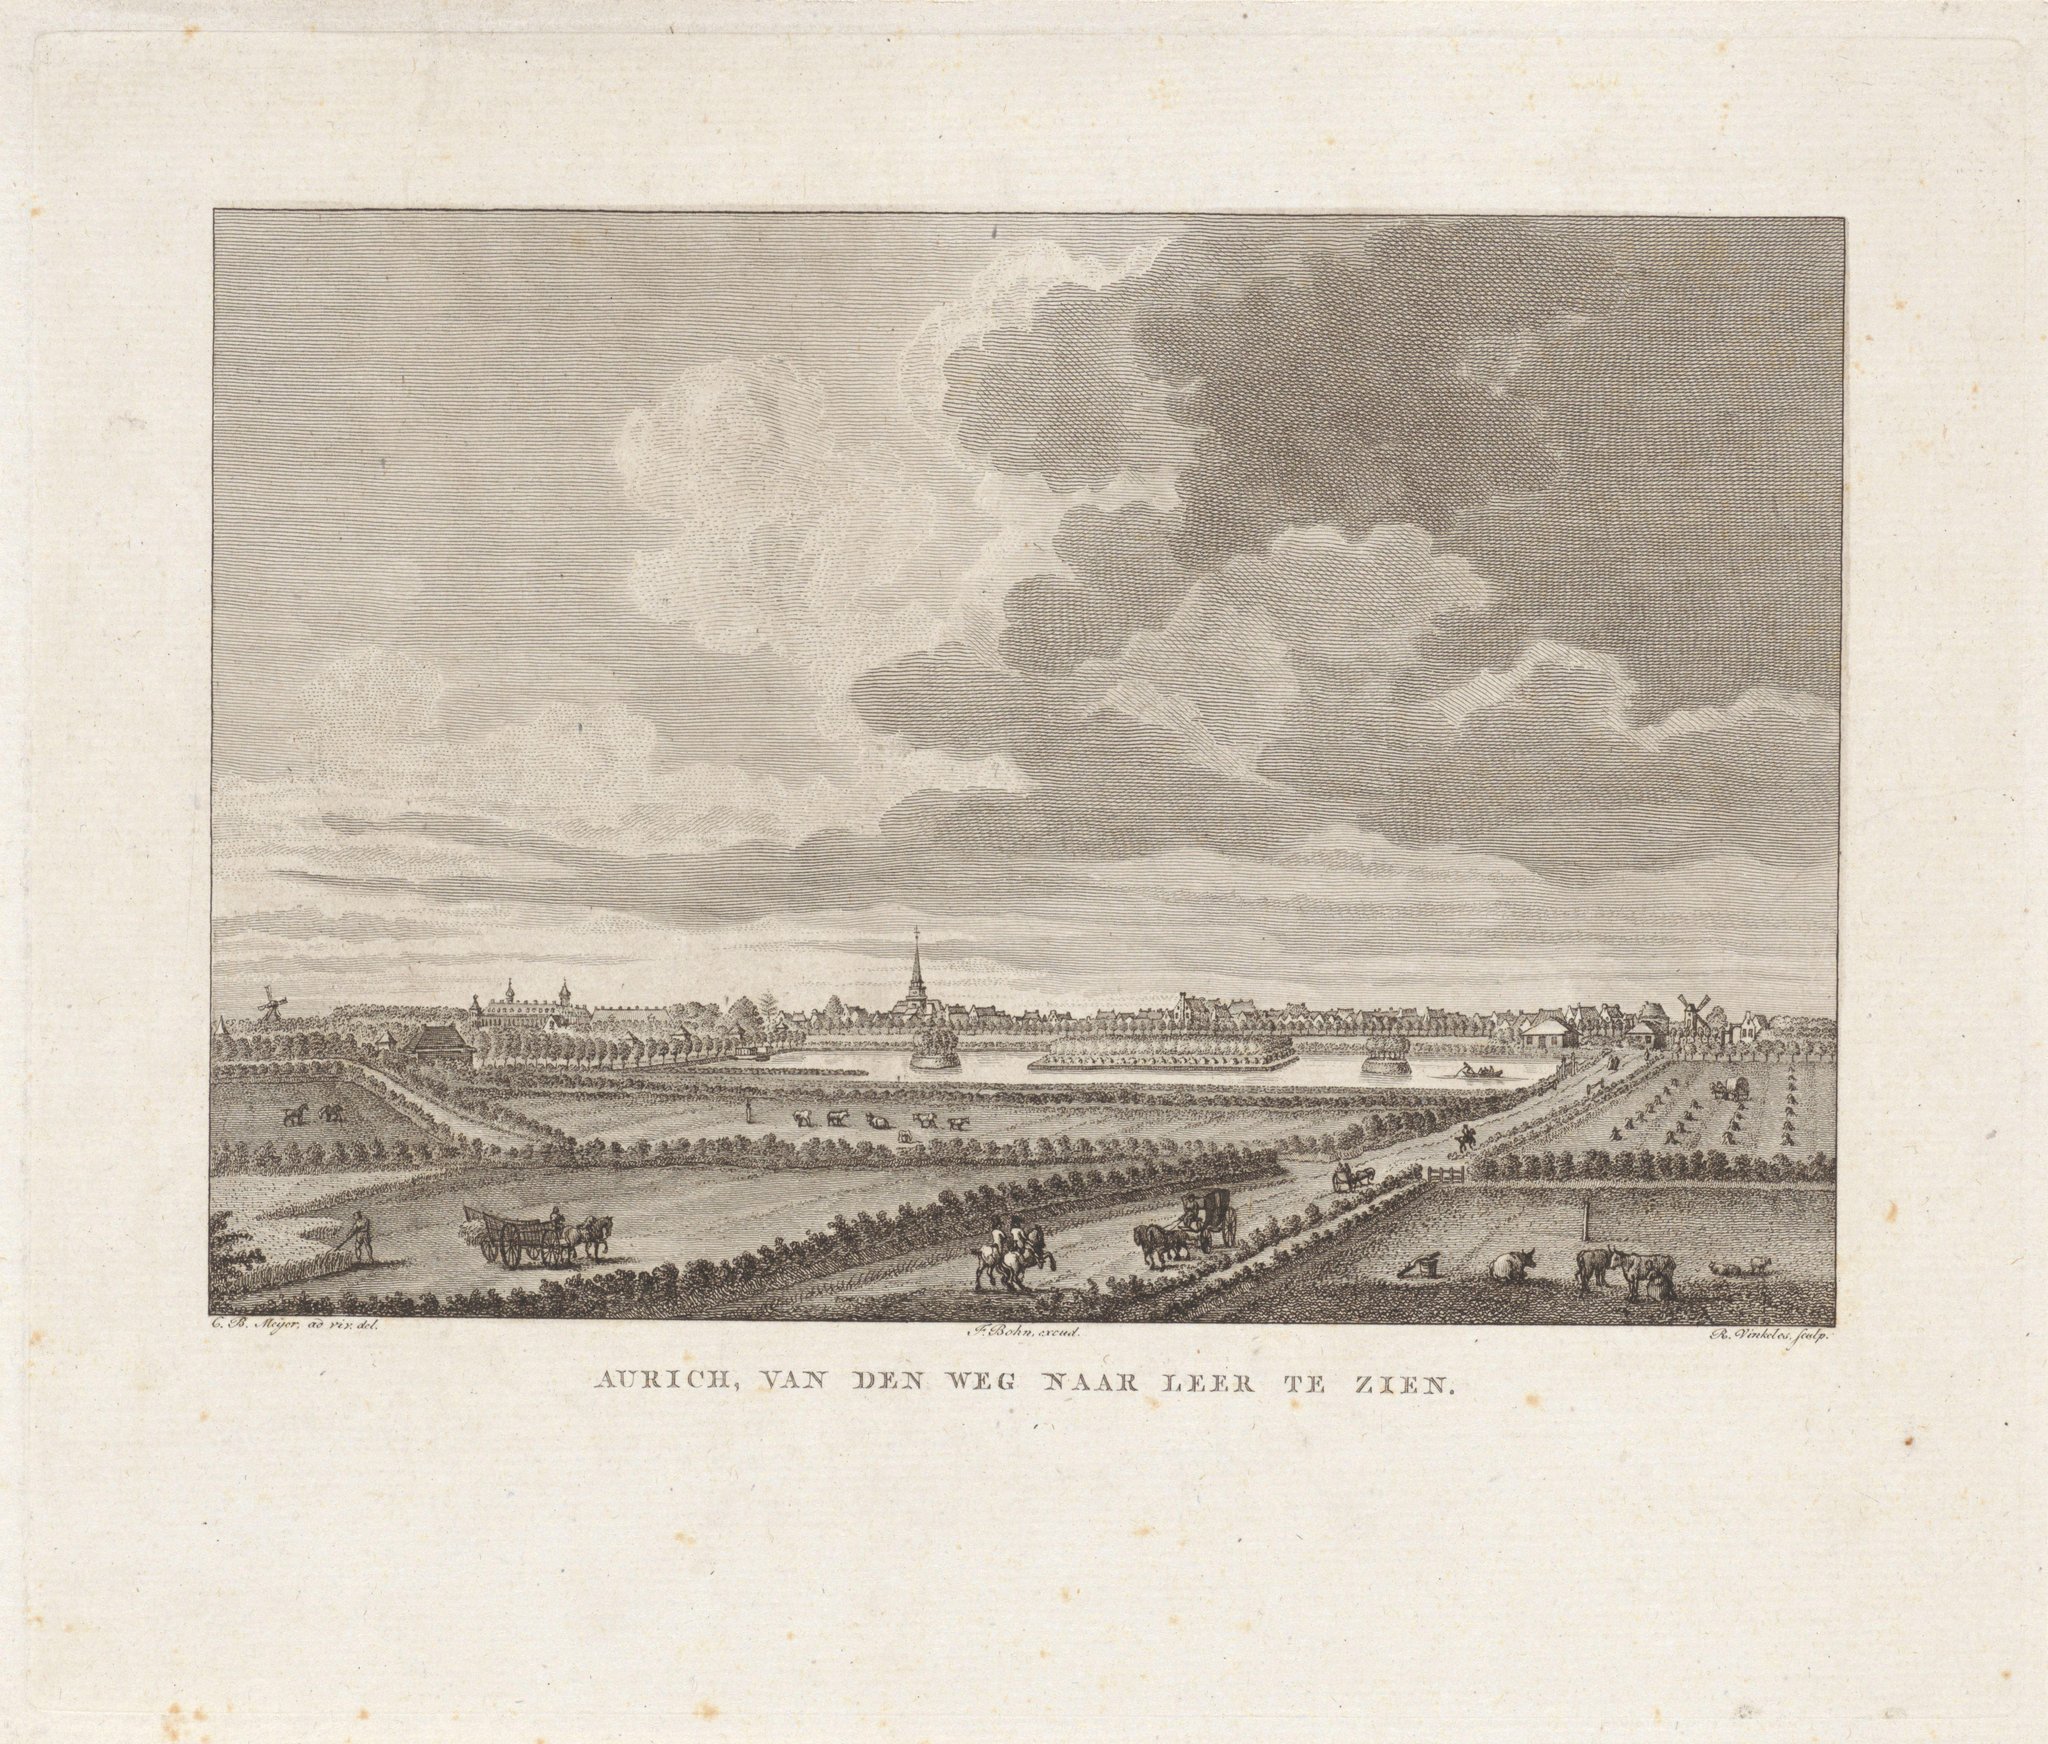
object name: print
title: Aurich, van den weg naar Leer te zien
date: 1751-1816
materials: paper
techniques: engraving, etching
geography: amsterdam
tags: city-view in general; 'veduta'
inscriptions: collector's mark: Lugt 2228